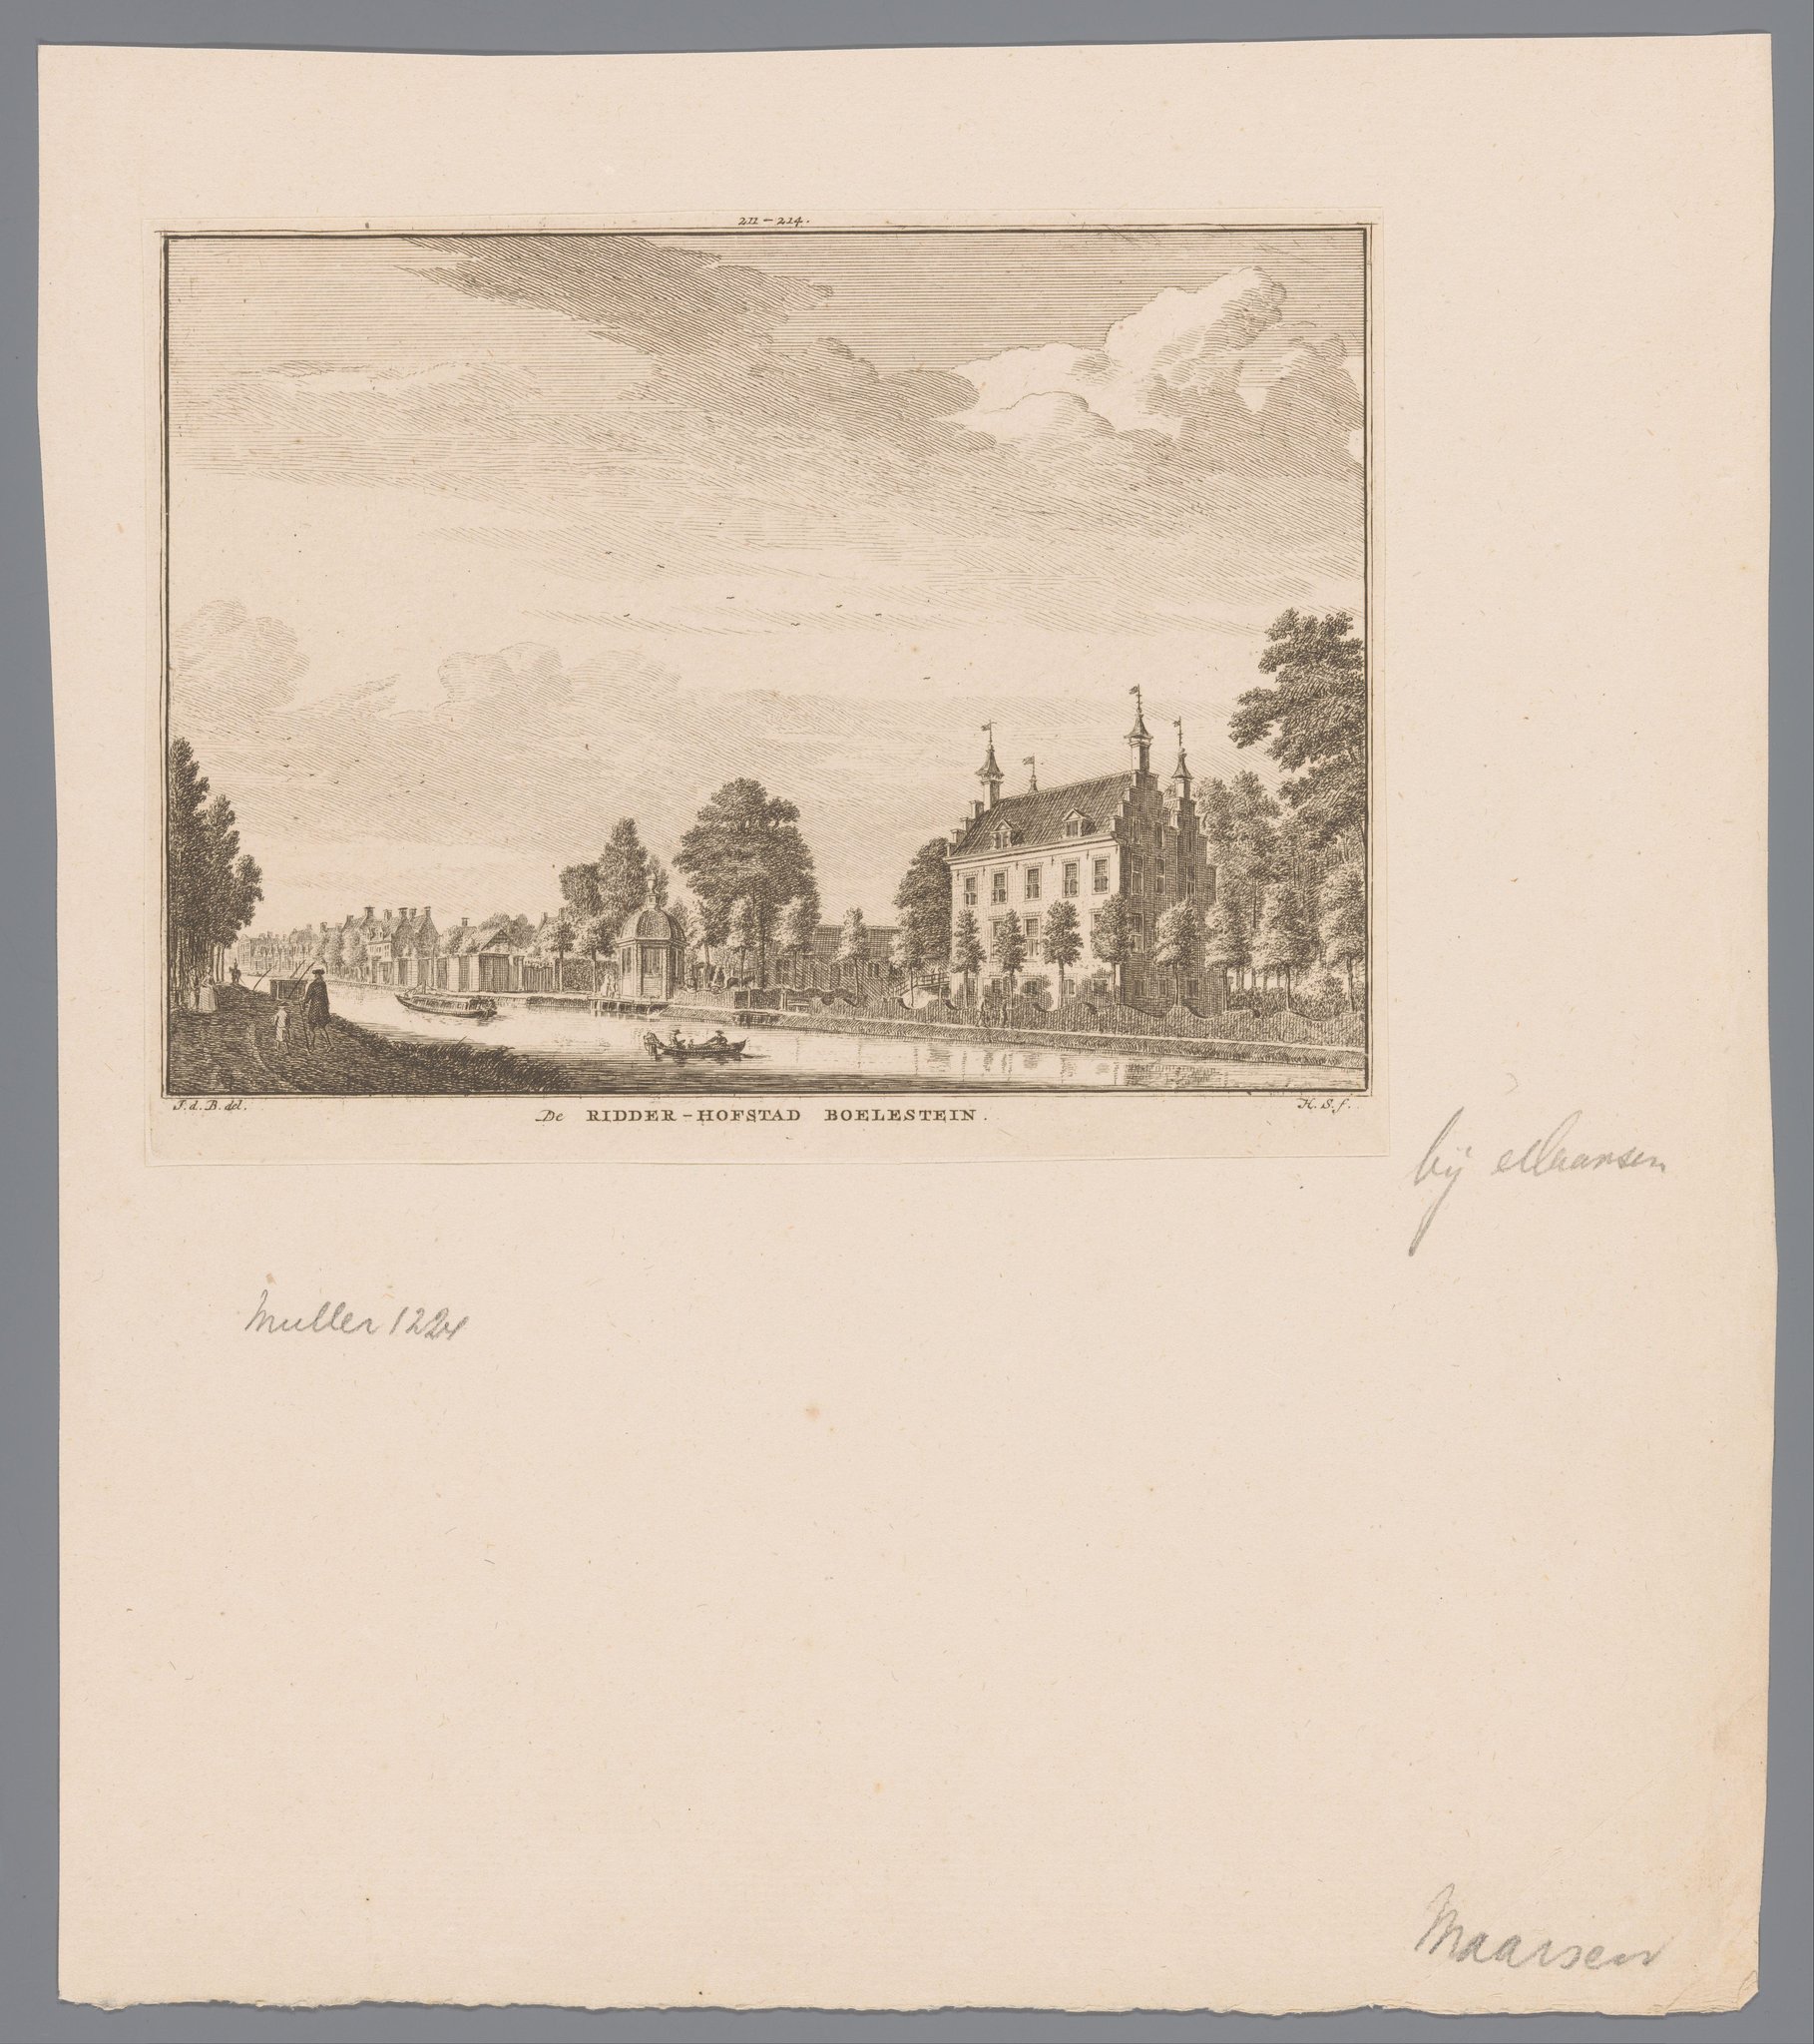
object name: print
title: Gezicht op huis Bolenstein aan de Vecht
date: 1745-1774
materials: paper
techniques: etching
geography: amsterdam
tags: castle, river, maarssen, vecht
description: Prent gebruikt in: Het verheerlykt Nederland of kabinet van hedendaagsche gezigten (...). Amsterdam: Isaac Tirion,1745-1774.